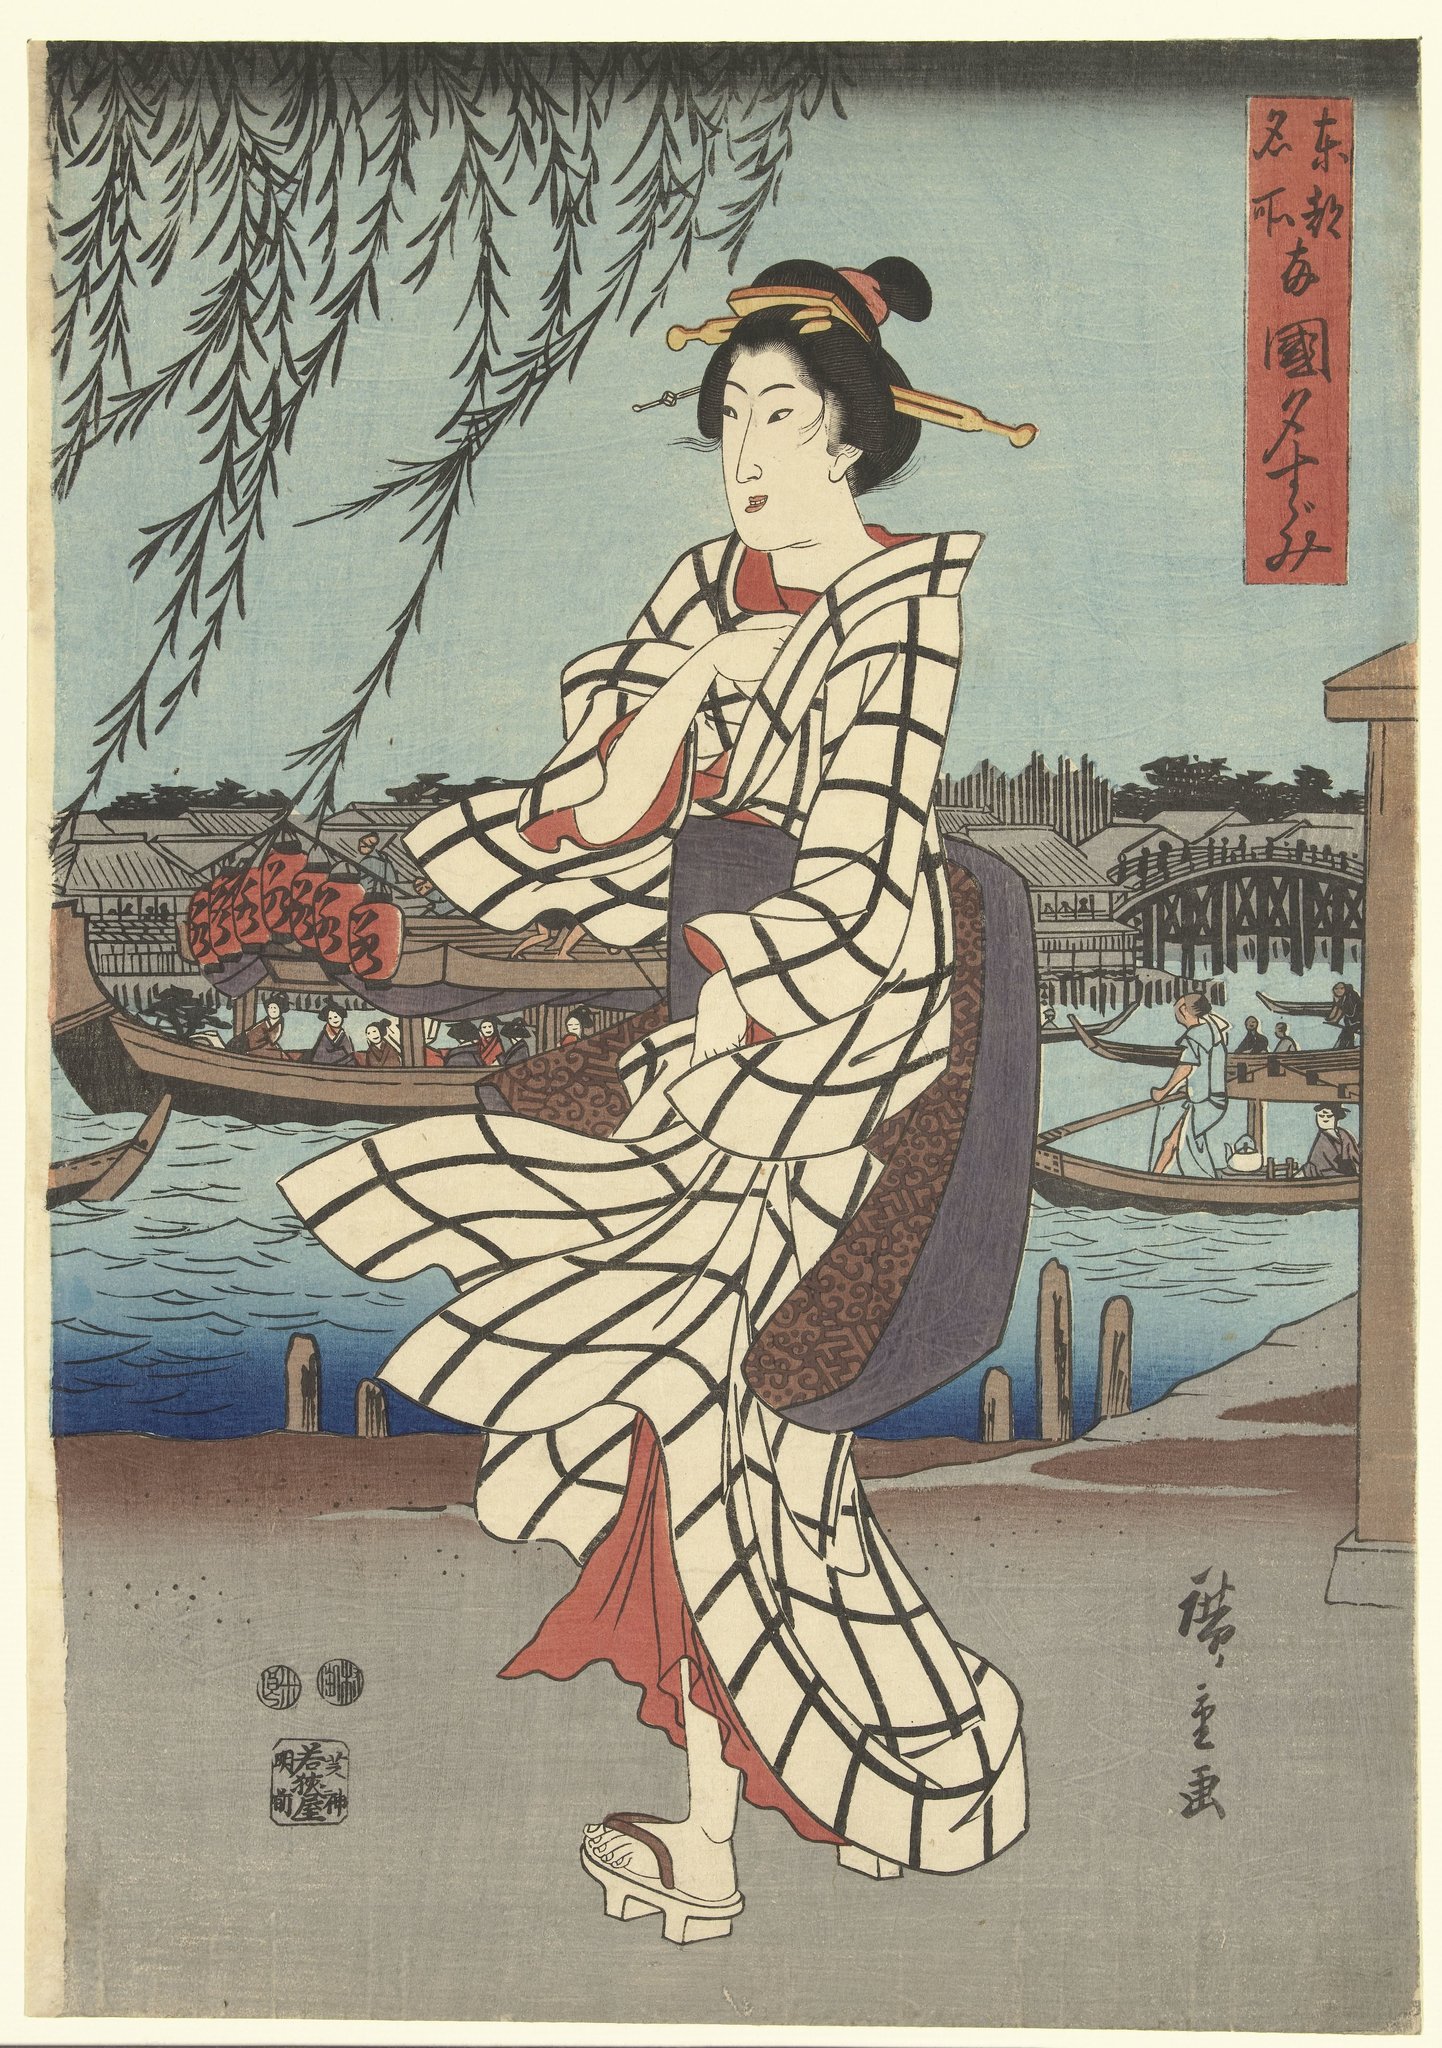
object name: print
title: Toto meisho Ryogoku no yusuzumi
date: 1847-1848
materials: paper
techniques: woodcut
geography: japan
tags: evening, river bank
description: Vrouw in zwart wit geruite zomer kimono, lopend op de oever van een druk bevaren rivier, onder wilgentakken, in de wind.